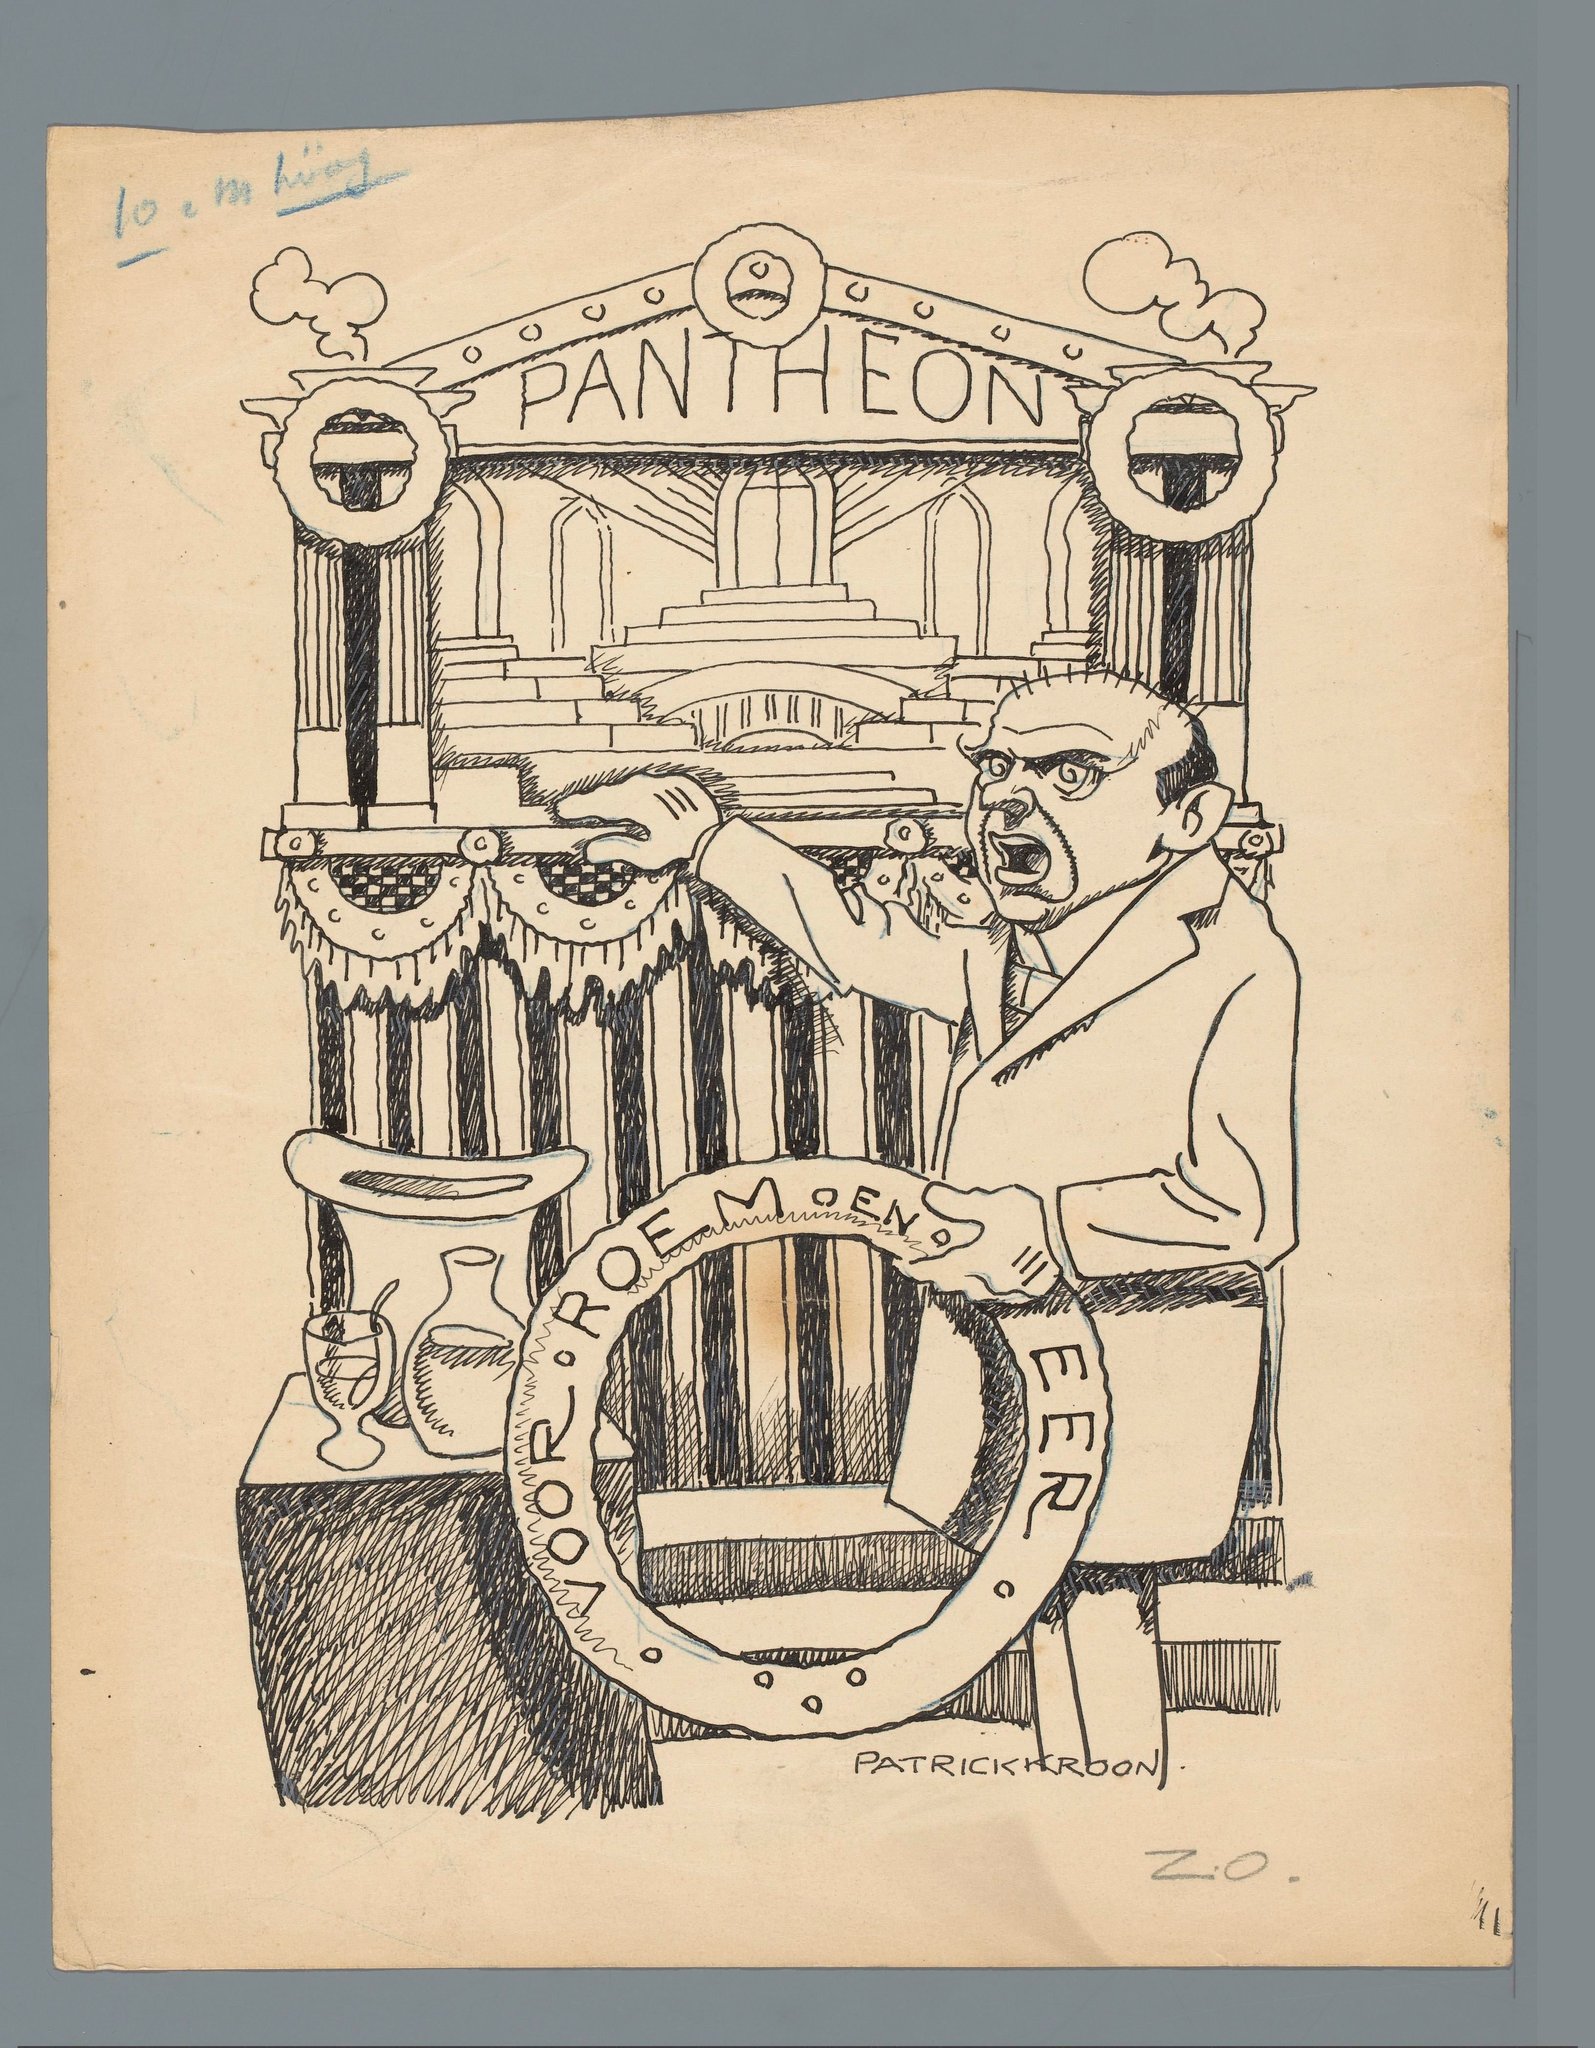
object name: cartoon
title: Op naar 't Pantheon!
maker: patricq kroon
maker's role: draughtsman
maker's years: 1862-1941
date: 1920-1930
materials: ink, paper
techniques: pen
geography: netherlands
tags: political caricatures and satires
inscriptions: inscription: ‘Op naar 't Pantheon! / Allo! Allo! Laat u de gelegenheid niet ontgaan! ...’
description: Een verkoper prijst het pantheon aan, in zijn hand een krans waarop 'Voor Roem en Eer'. Ontwerp voor een politieke spotprent.